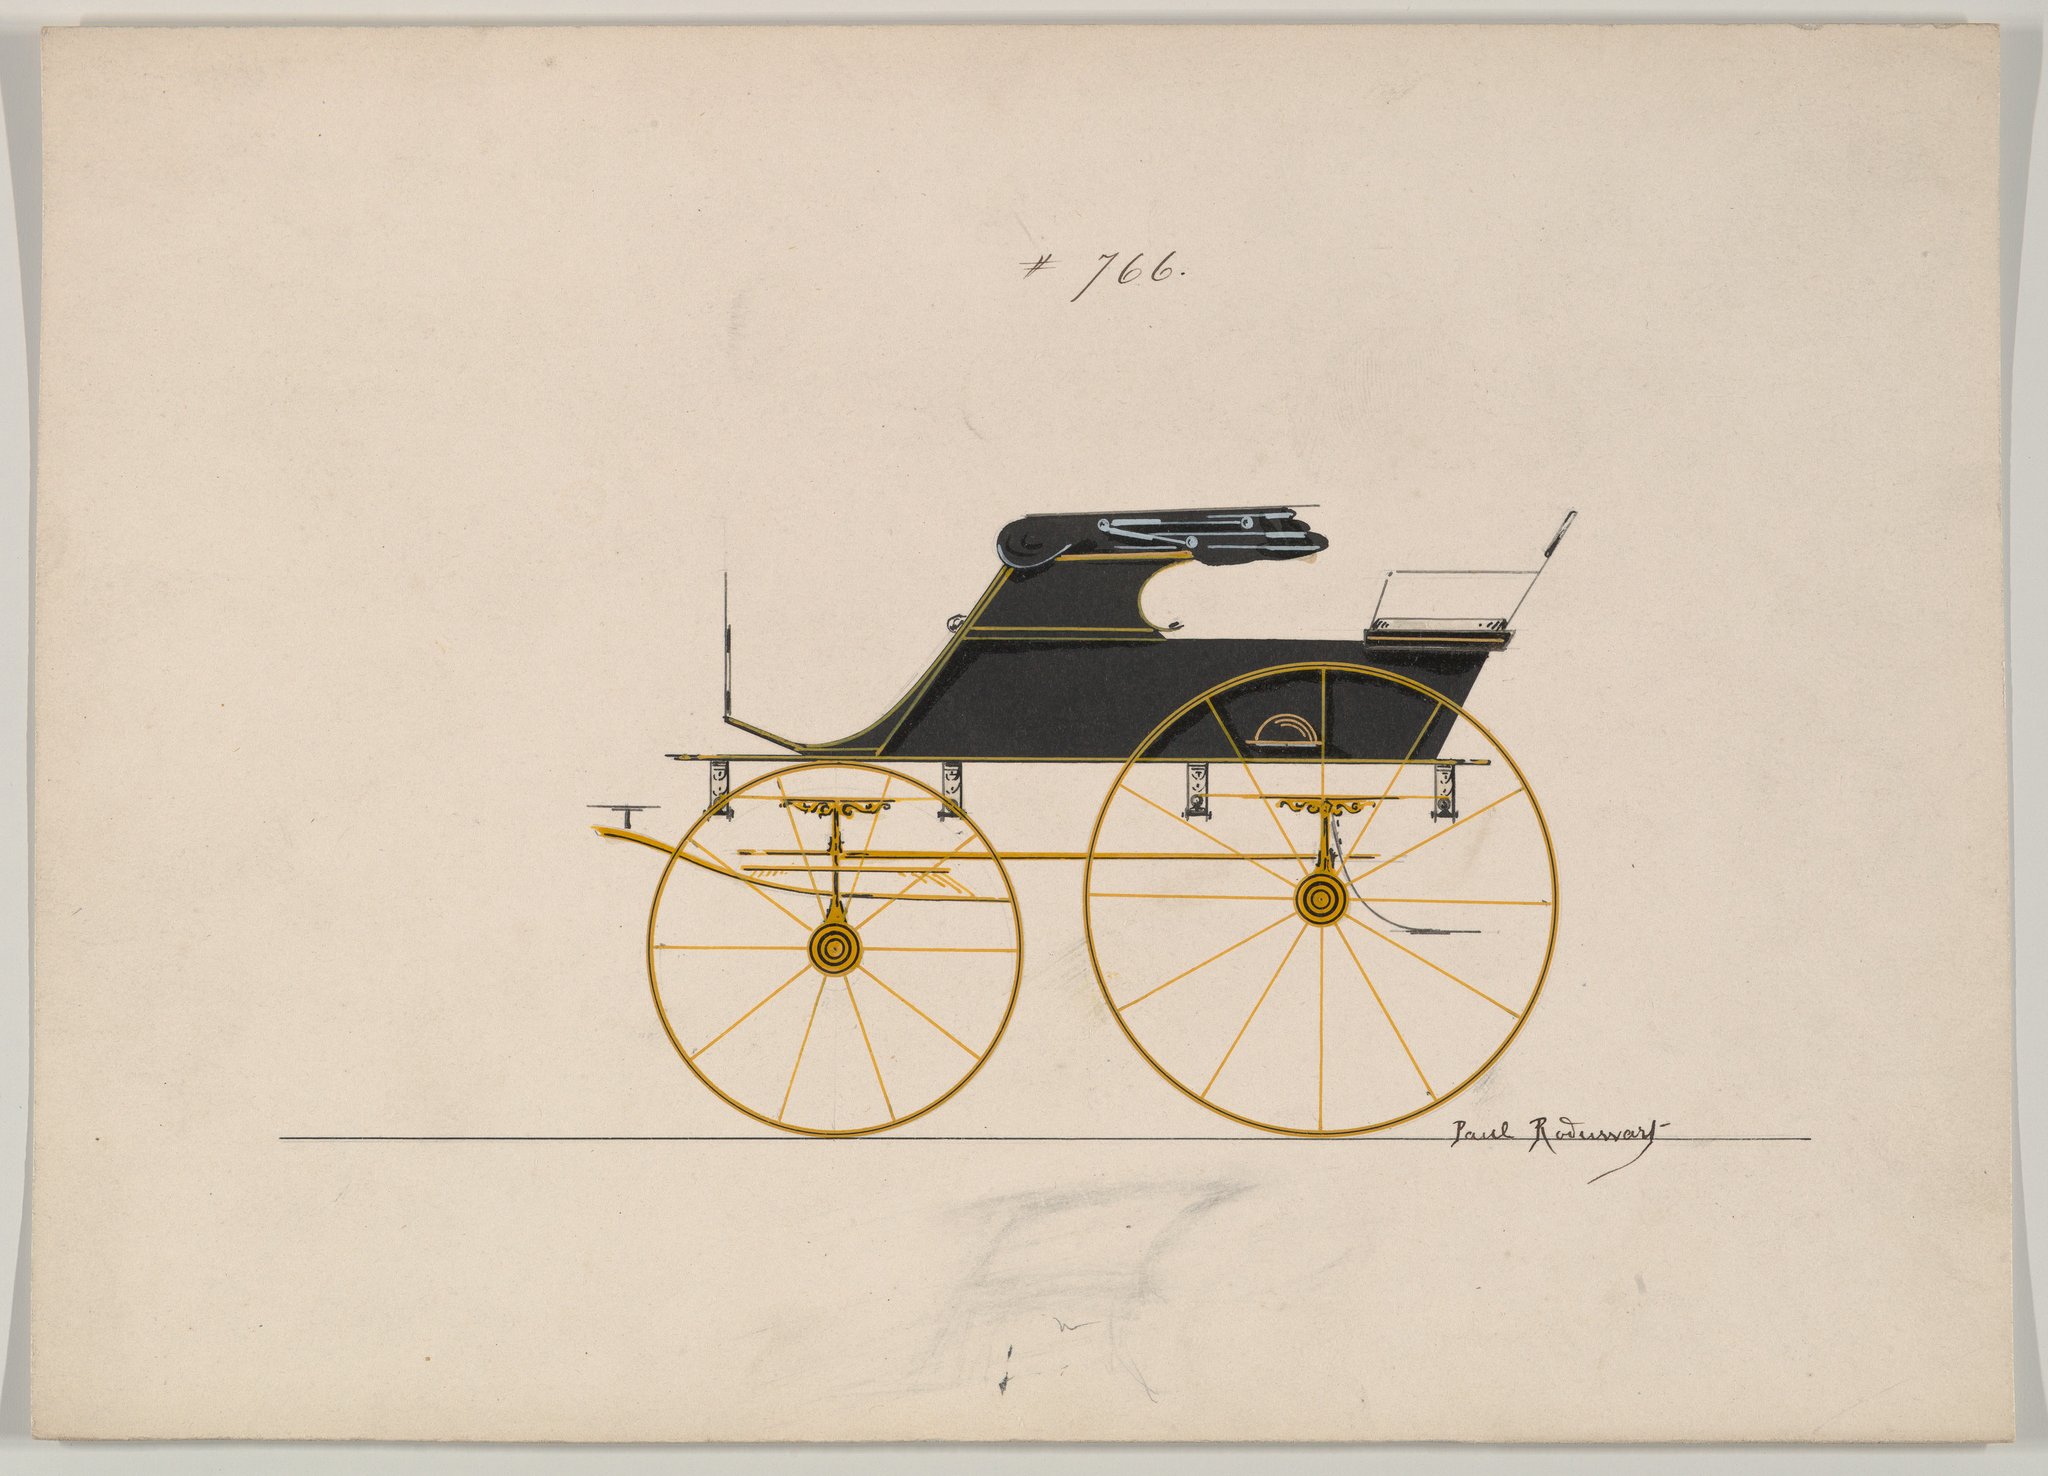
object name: drawing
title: Design for Phaeton, no. 766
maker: brewster & co.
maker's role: manufacturer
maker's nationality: american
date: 1850-1874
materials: gouache, gum arabic, ink, watercolor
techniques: pen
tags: carriages